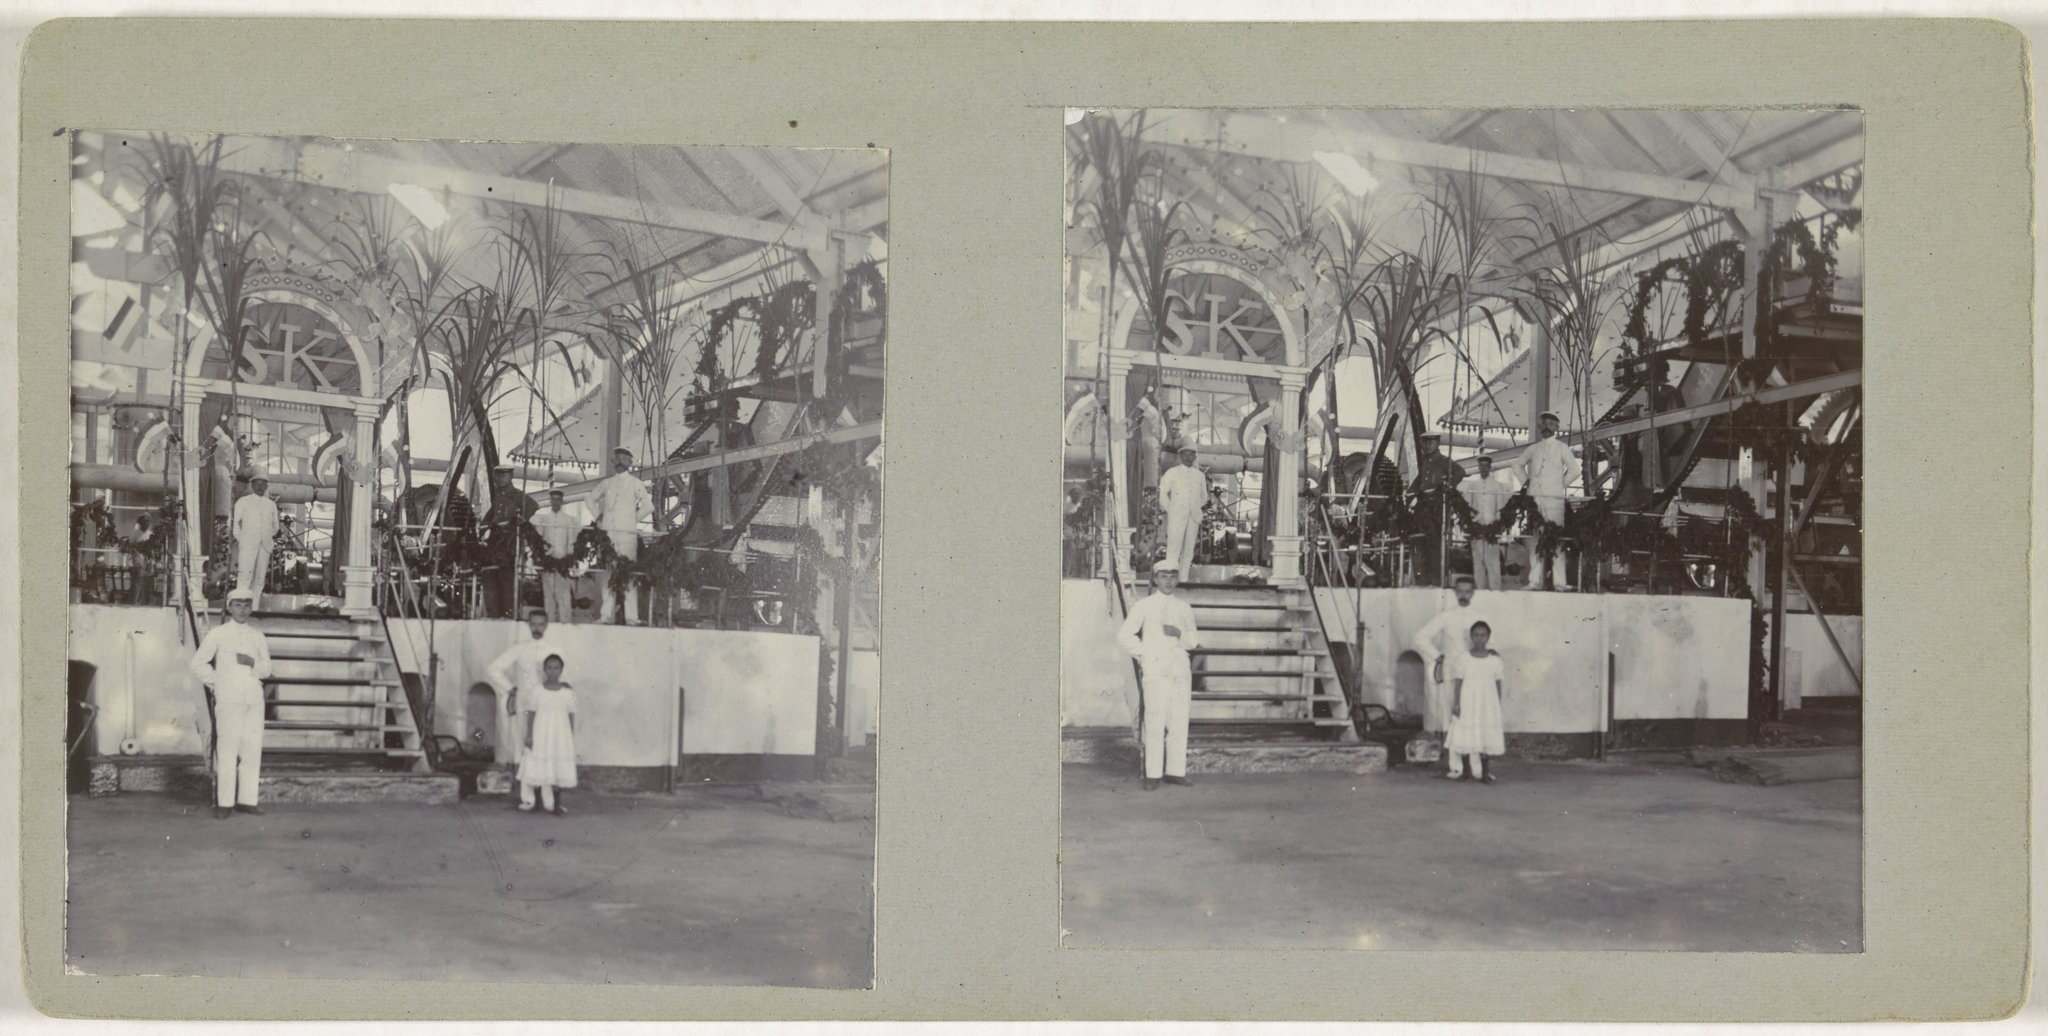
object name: stereograph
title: Mensen poserend in suikerfabriek (?) Soemberkareng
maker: Anonymous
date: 1906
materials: cardboard, paper, photographic support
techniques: albumen print